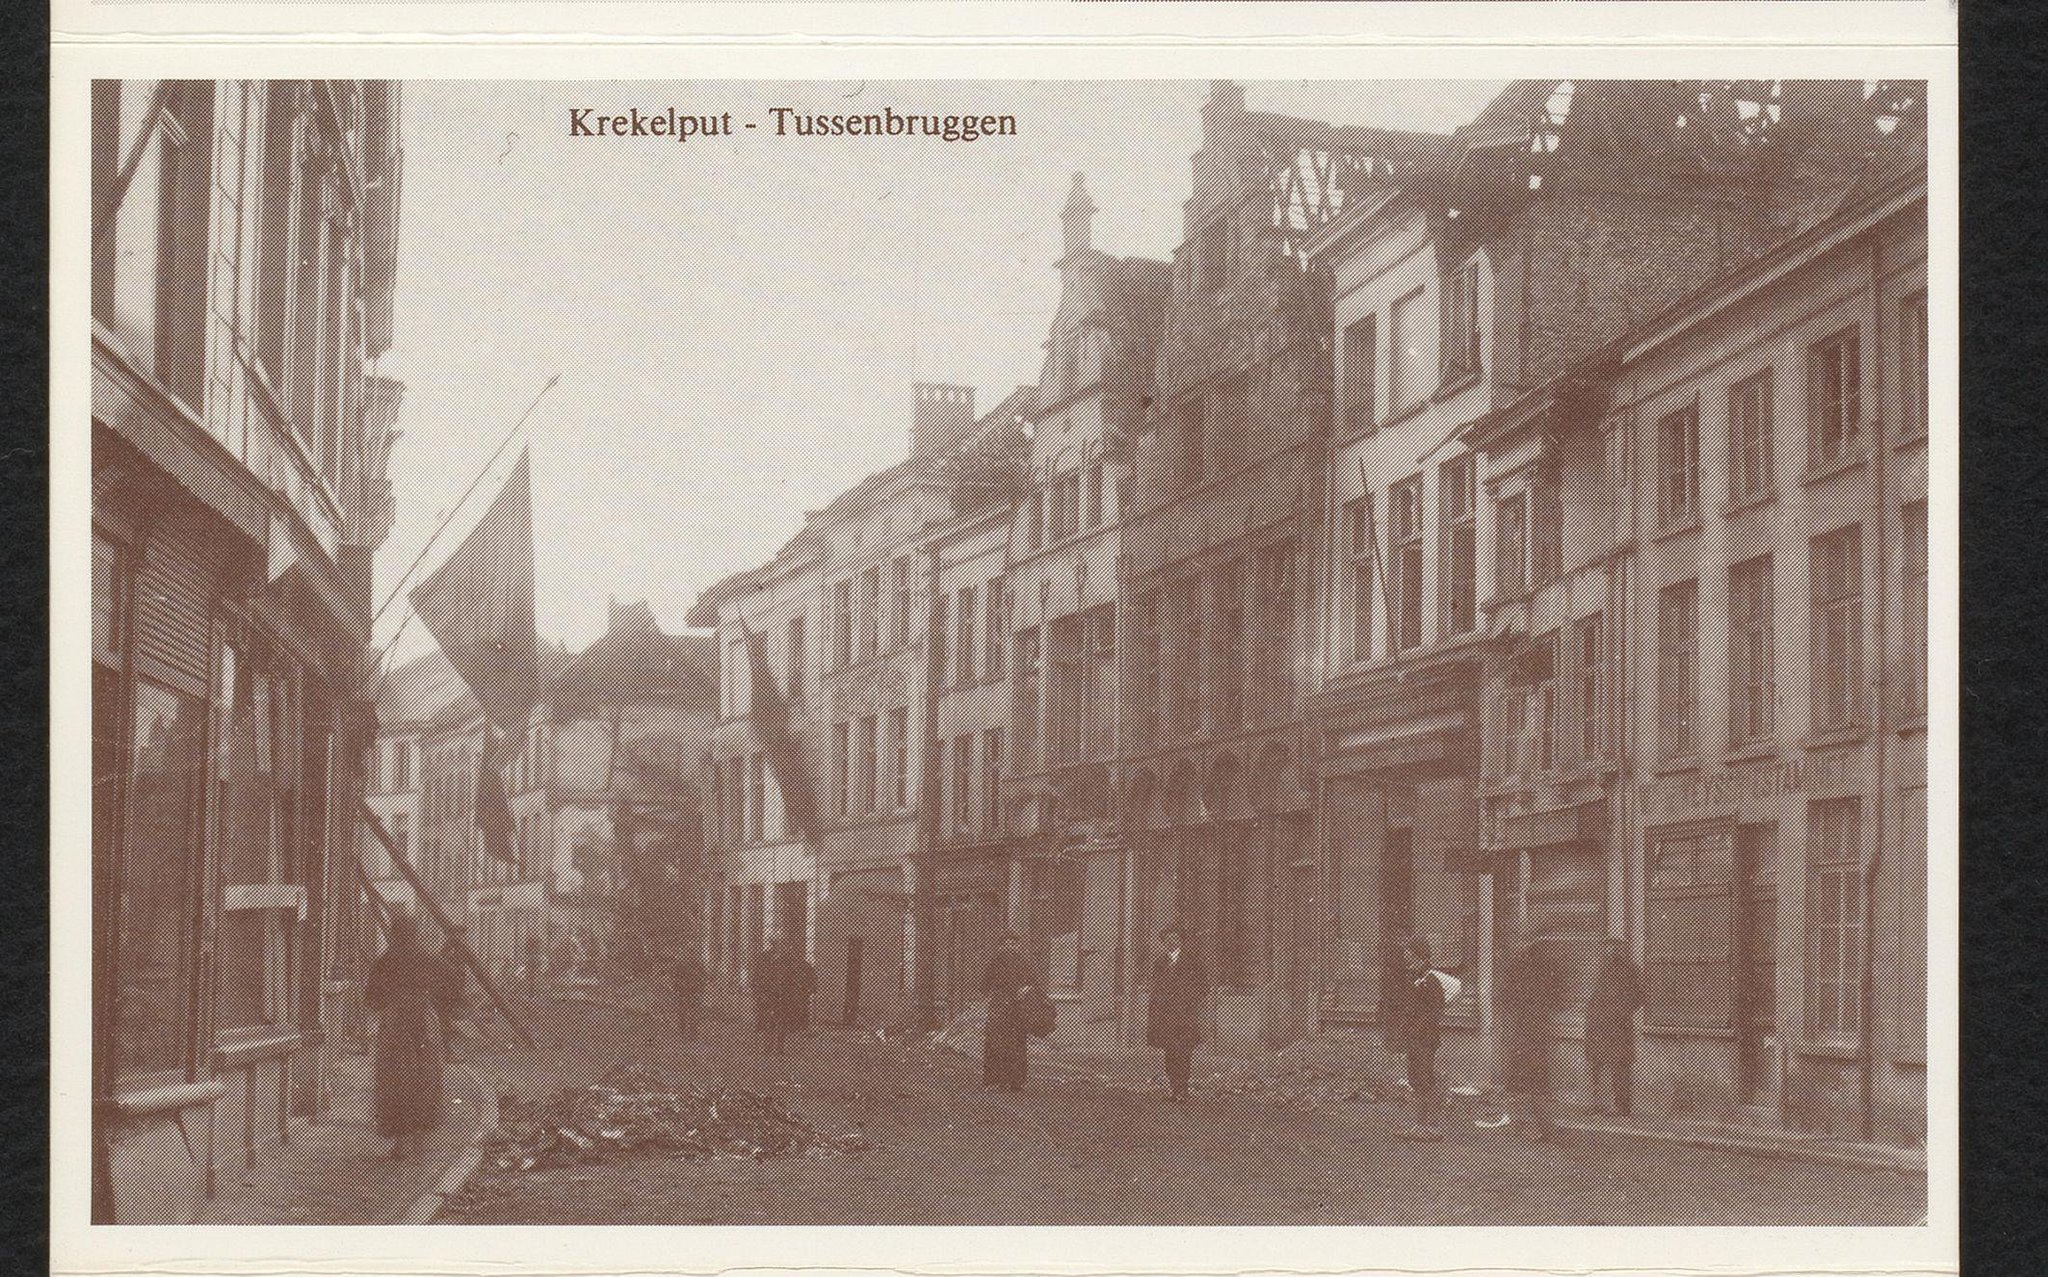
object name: ansichtkaart, prentbriefkaart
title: Krekelput. Tussenbruggen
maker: Anonymous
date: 1981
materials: cardboard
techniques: offset printed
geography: oudenaarde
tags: consequences of war, city-view, and landscape with man-made constructions (+ city(-scape) with figures, staffage), street (+ city(-scape) with figures, staffage)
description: Deze prentbriefkaart is een reproductie van een oudere prentbriefkaart.